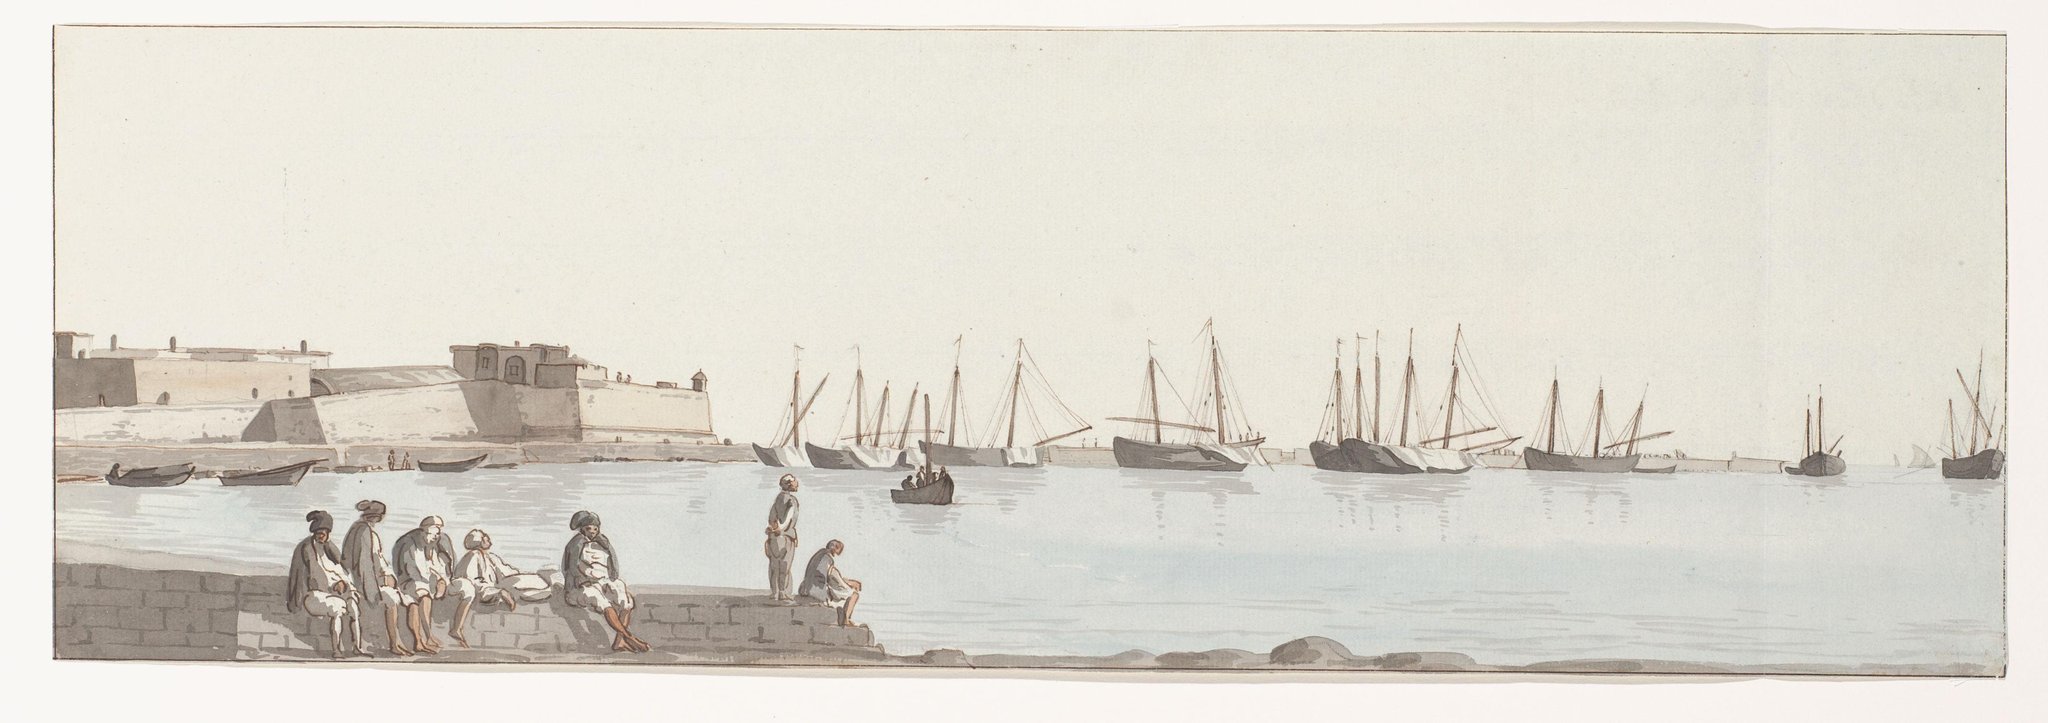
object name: watercolor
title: Gezicht op de rede met schepen voor anker bij Bari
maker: louis ducros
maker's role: draughtsman, print maker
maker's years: 1748-1810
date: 1778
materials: chalk, paper, watercolor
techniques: brush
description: Tekening uit het album 'Voyage en Italie, en Sicile et à Malte', 1778.